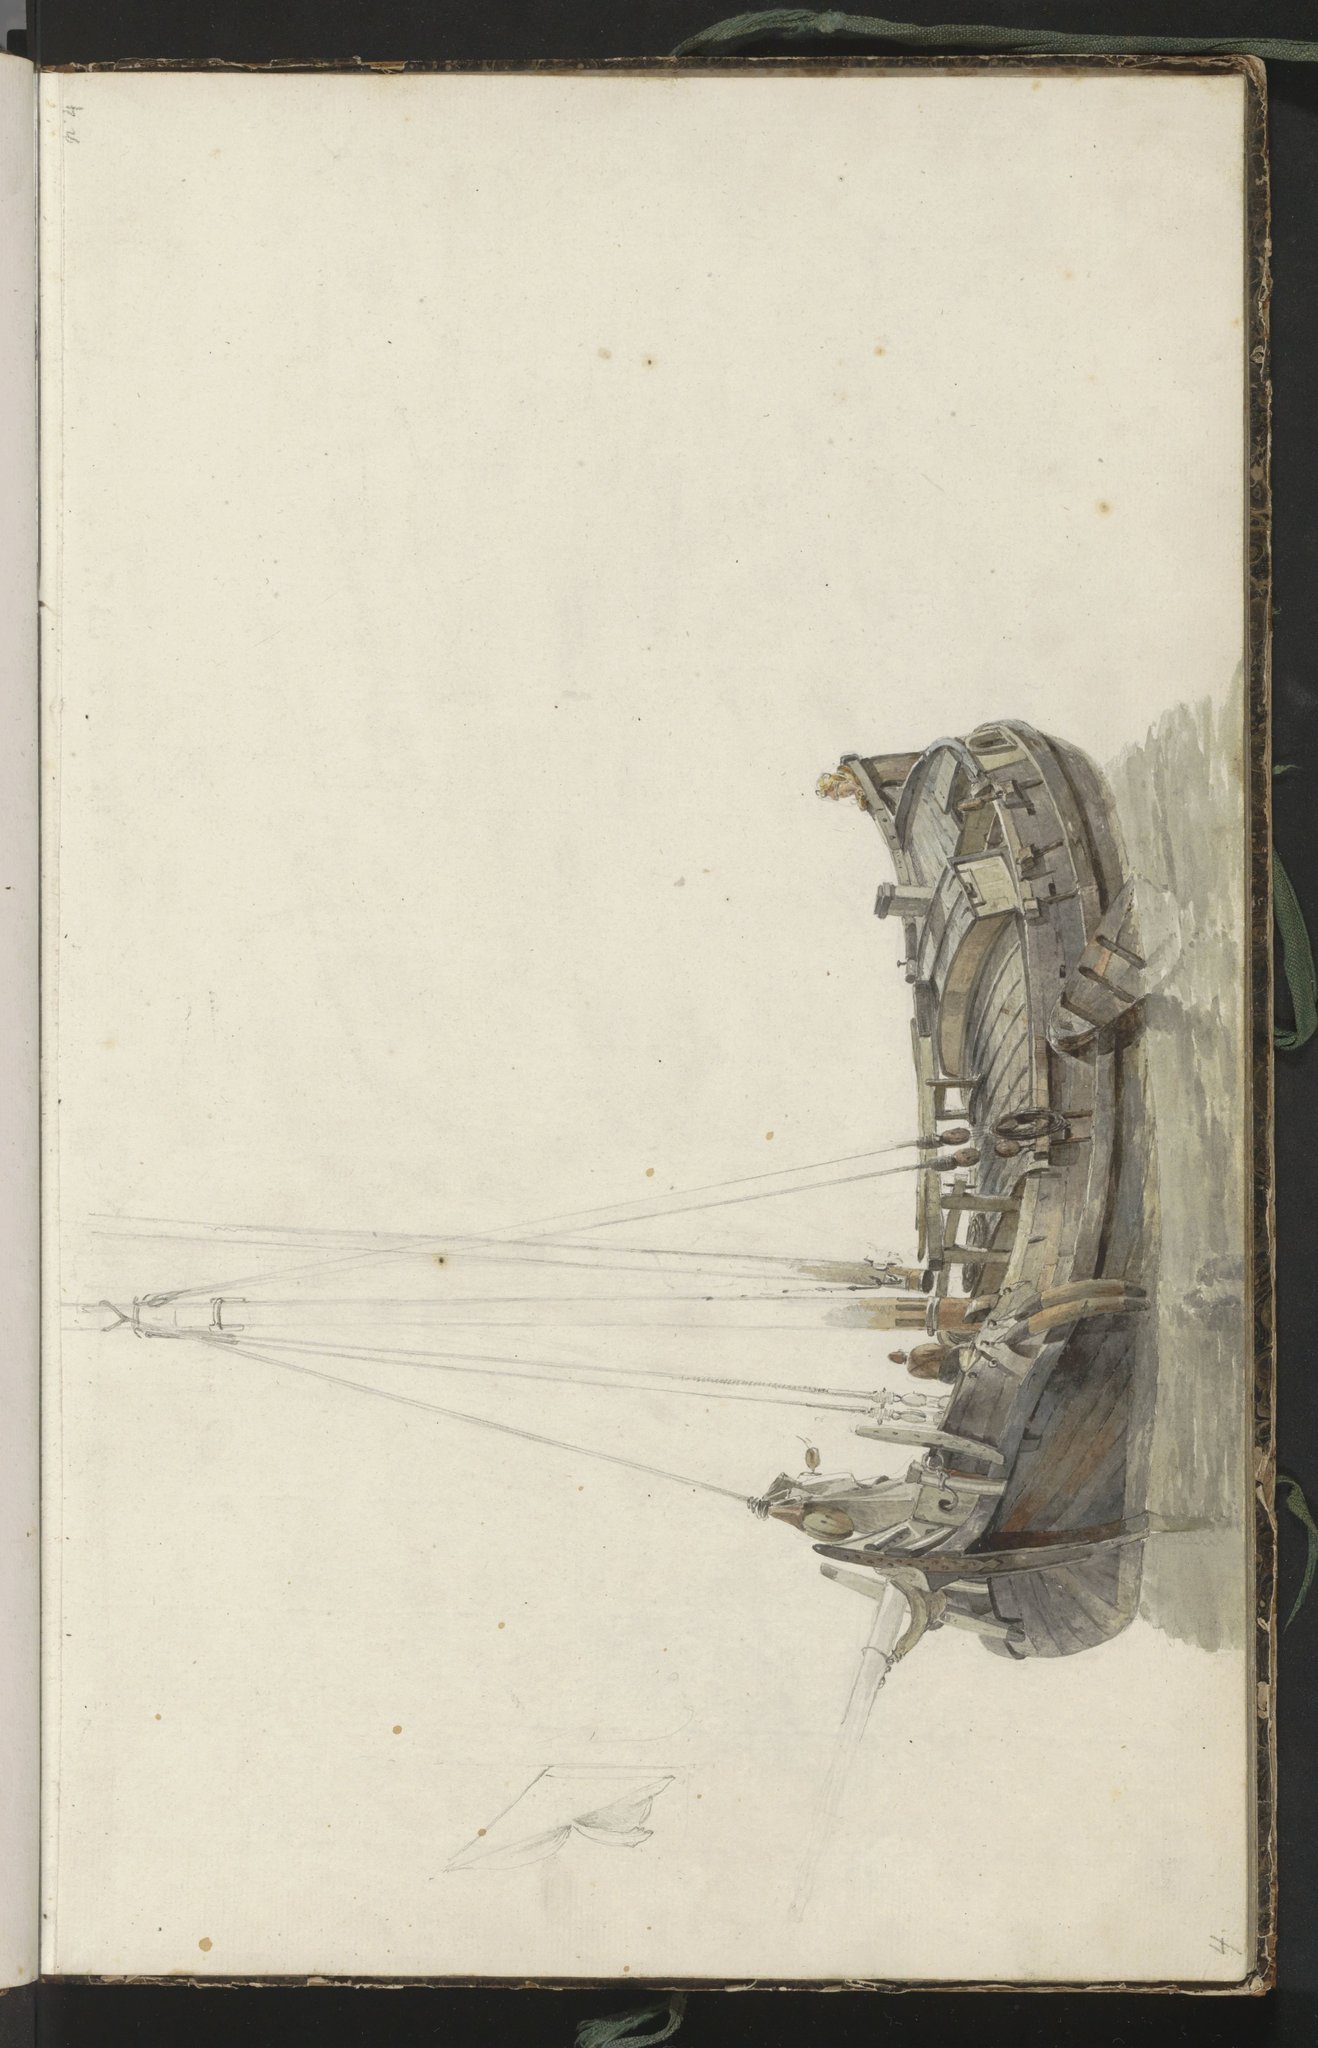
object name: sketchbook leaf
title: Zeeuwse poon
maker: johannes christiaan schotel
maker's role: draughtsman, painter, print maker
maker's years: 1787-1838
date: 1797-1838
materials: paper, pencil, watercolor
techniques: brush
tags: sail, sailing-ship, sailing-boat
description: Zeeuwse ponen werden in de delta veel gebruikt in de beurtvaart, waarbij er een vaste verbinding werd onderhouden tussen twee havens en het beurtschip op vaste tijden vertrok. Zowel passagiers als vracht werd er met deze beurtschepen vervoerd. Voor de passagiers die het konden betalen was er een plaats in het verwarmde paviljoen in het achterschip, waar banken met kussens het verblijf tijdens de reis voor extra comfort zorgden. De minder vermogenden kregen een plek in het ruim tijdens de overtocht. Ponen kwamen ook voor in de gewone vrachtvaart, maar het paviljoen werd dan voor bewoning door de schipper gebruikt.